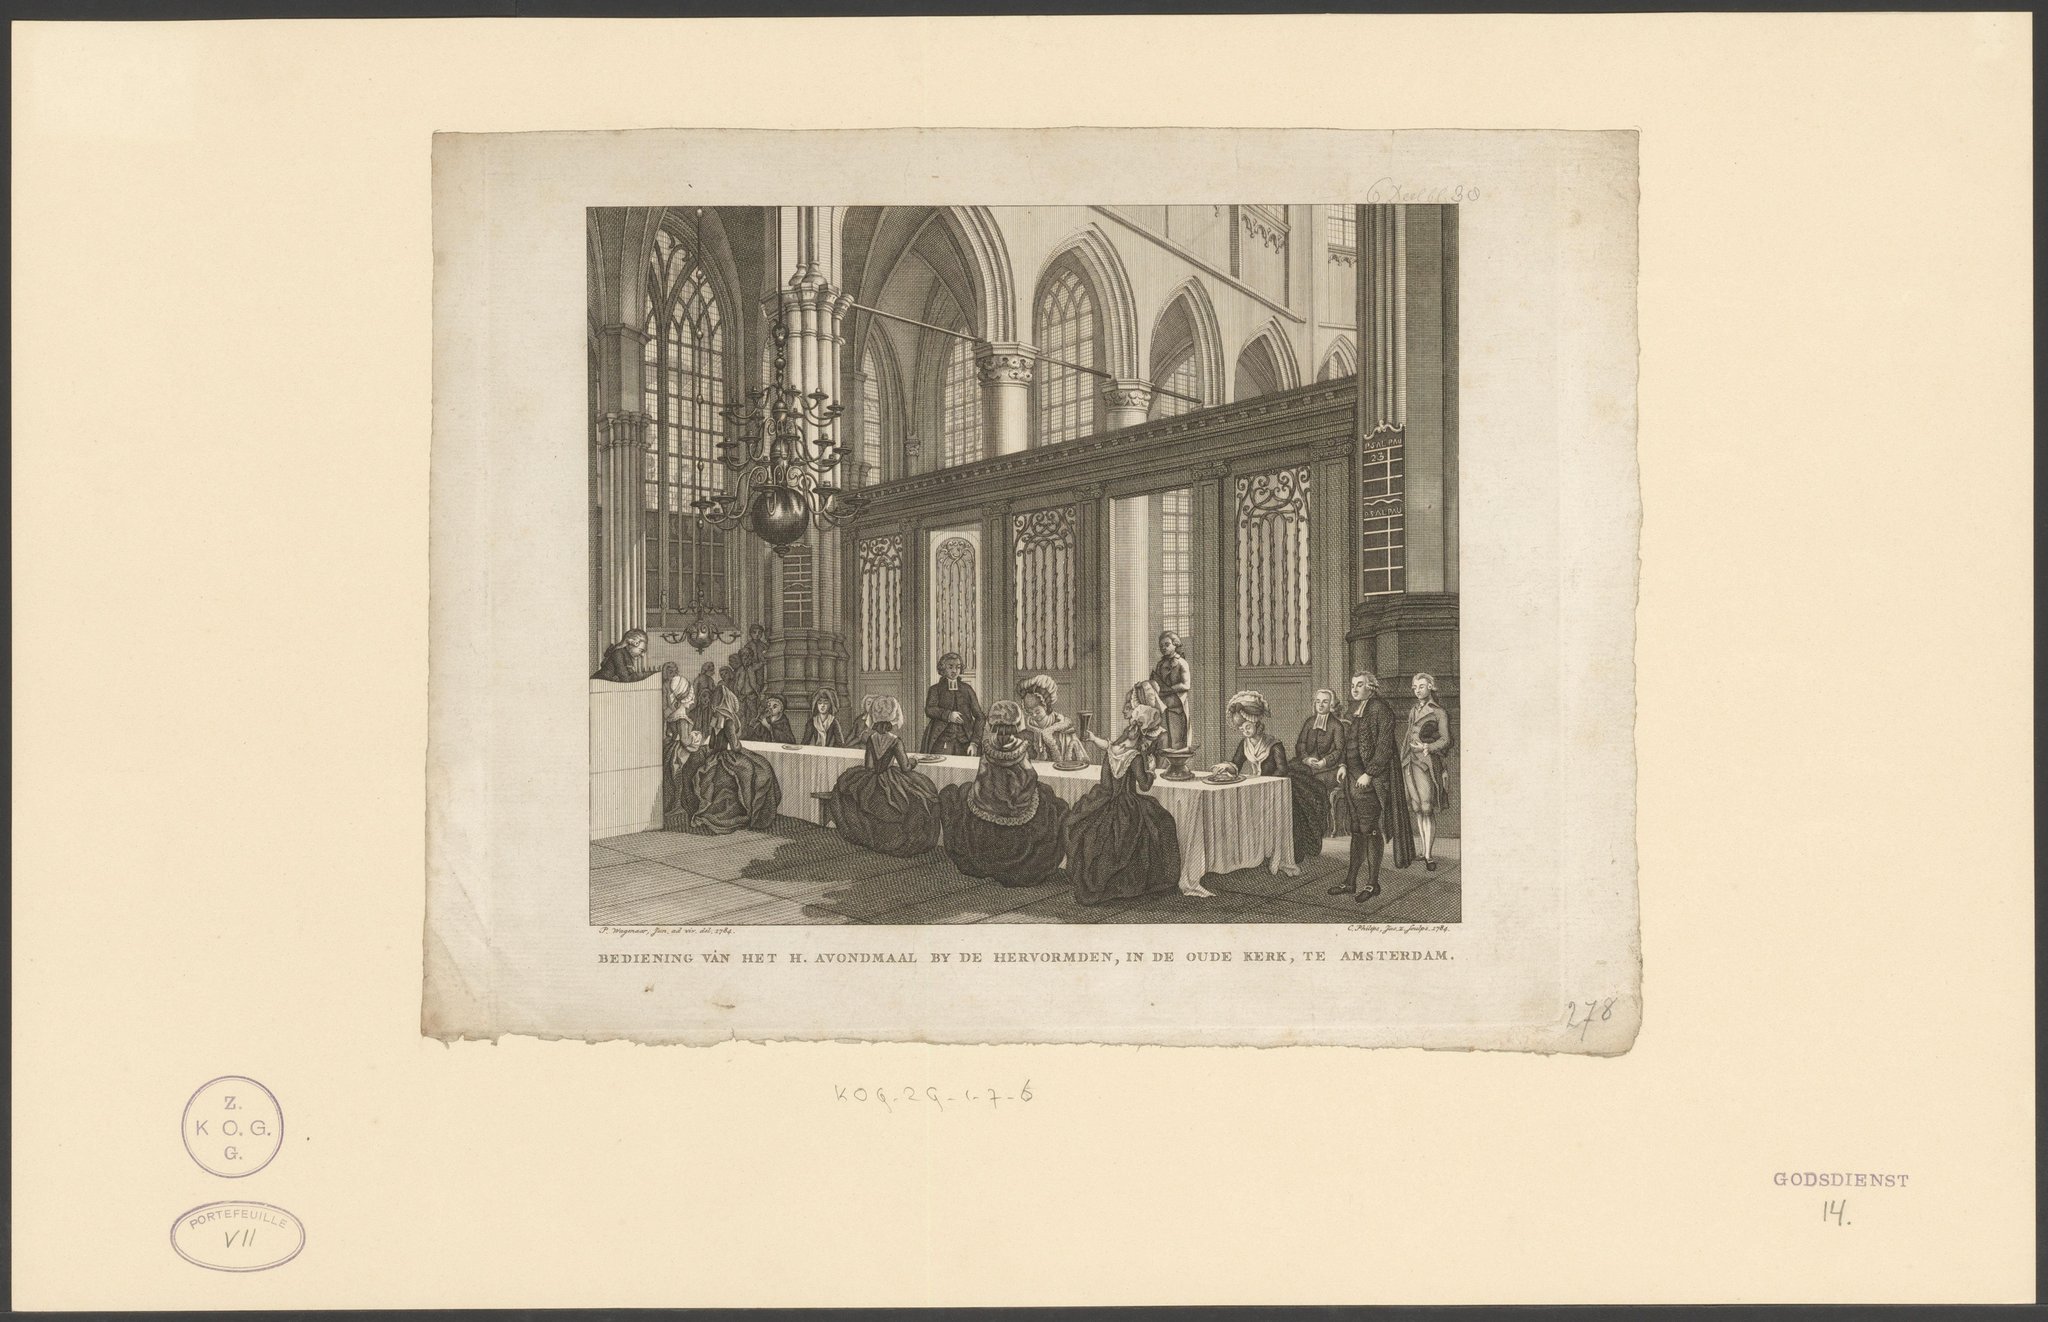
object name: print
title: Bediening van het H. avondmaal by de hervormden, in de Oude Kerk, te Amsterdam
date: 1784-1785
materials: paper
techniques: etching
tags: interior of church, evening meal, dinner, supper, prayer at table, saying grace, parts of church interior: choir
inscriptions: collector's mark: Lugt 1641, stamp, stamp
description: Prent waarschijnlijk uit: Hurd, William. Oude en tegenwoordige Staat en geschiedenis van alle godsdiensten (...). Amsterdam: Martinus de Bruyn, 1785, dl. 6.